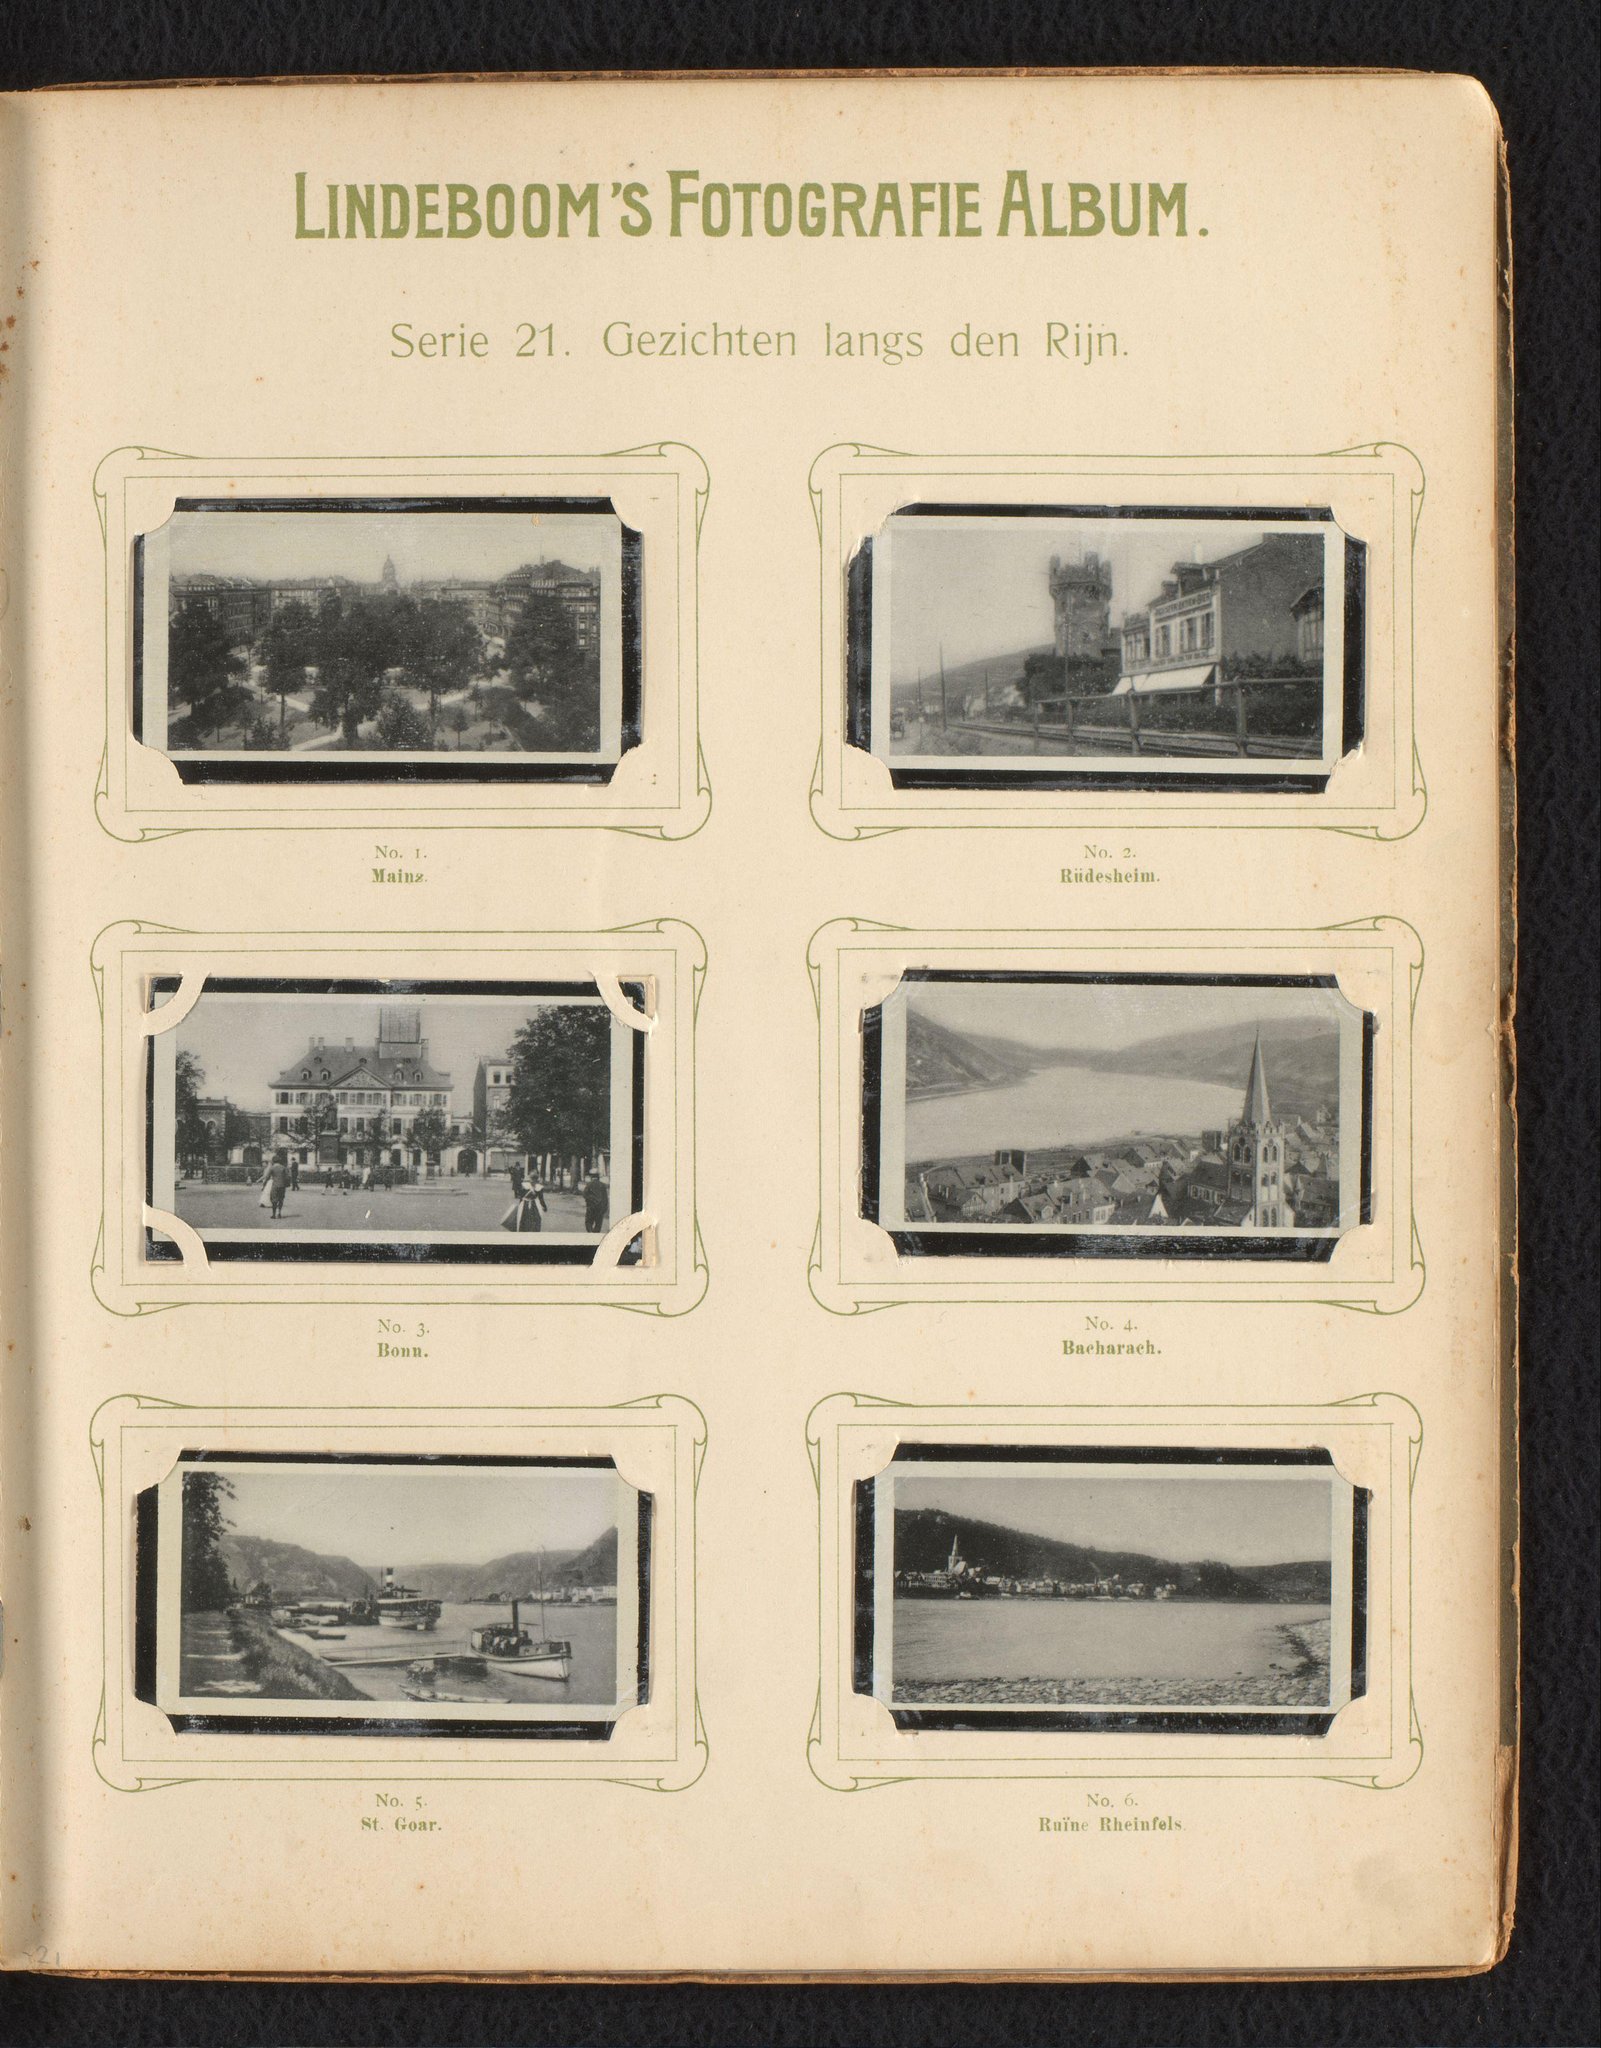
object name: album leaf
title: Zes reproducties van gefotografeerde stadsgezichten uit Mainz, Rüdesheim, Bonn, Bacharach, Sankt Goar en de Burcht Rheinfels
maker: Anonymous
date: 1905-1906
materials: cardboard, paper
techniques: photograph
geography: amsterdam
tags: city-view in general; 'veduta'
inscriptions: inscription: ‘Serie 21.’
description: Dergelijke prenten stonden bekend als 'zwartjes'. Men verkreeg ze bij aanschaf van bepaalde merken thee, cacao, sigaretten, beschuit, etc. om te verzamelen. Er waren speciaal voor de 'zwartjes' vervaardigde verzamelalbums in omloop.